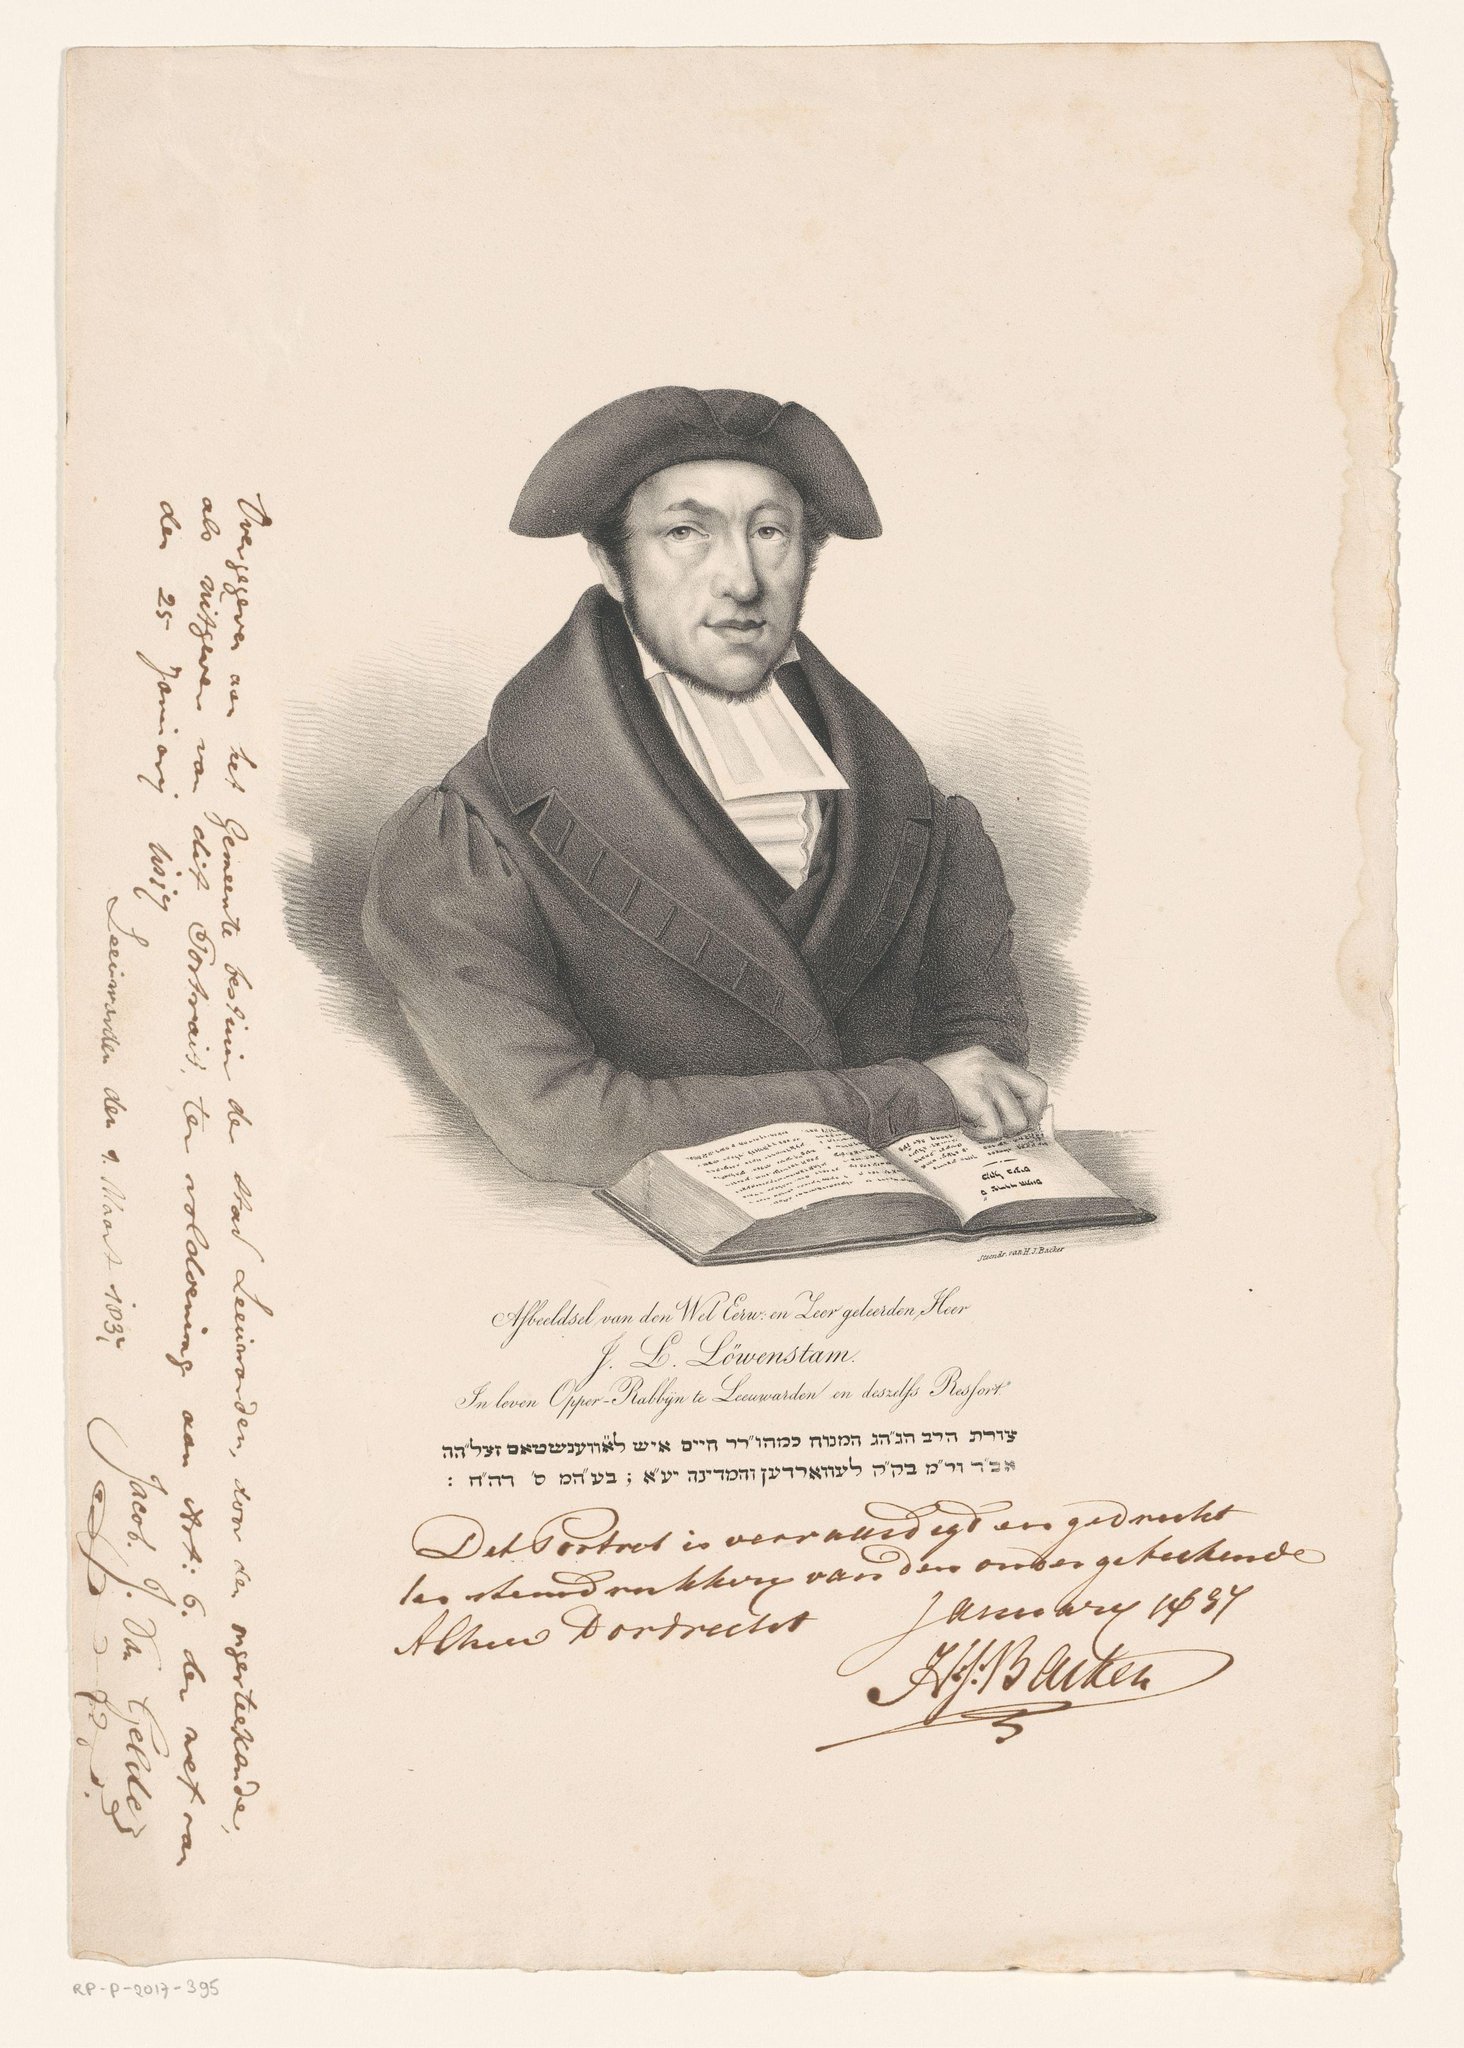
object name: print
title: Portret van Joachim Loewenstam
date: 1837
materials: paper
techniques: lithograph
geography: dordrecht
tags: historical persons (+ half-length portrait), chief rabbi, studying the torah, the talmud, etc. ~ personal duties in jewish life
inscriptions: : ‘Overgegeven aan het gemeente bestuur der stad Leeuwarden, door den ondergeteekende, / als uitgever van dit Portrait, ter voldoening aan Art: 6 der wet van / den 25 january 1817 / Leeuwarden den 1 maart 1837 Jacob J. van Gelder’, : ‘Dit portret is vervaardigd en gedrukt / ter steendrukkerij van den ondergeteekende / alhier Dordrecht january 1837 / H.J. Backer’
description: De geportretteerde zit aan tafel met voor zich een opengeslagen Thora. Onder het portret zijn naam, beroep en een tekst in het Hebreeuws.